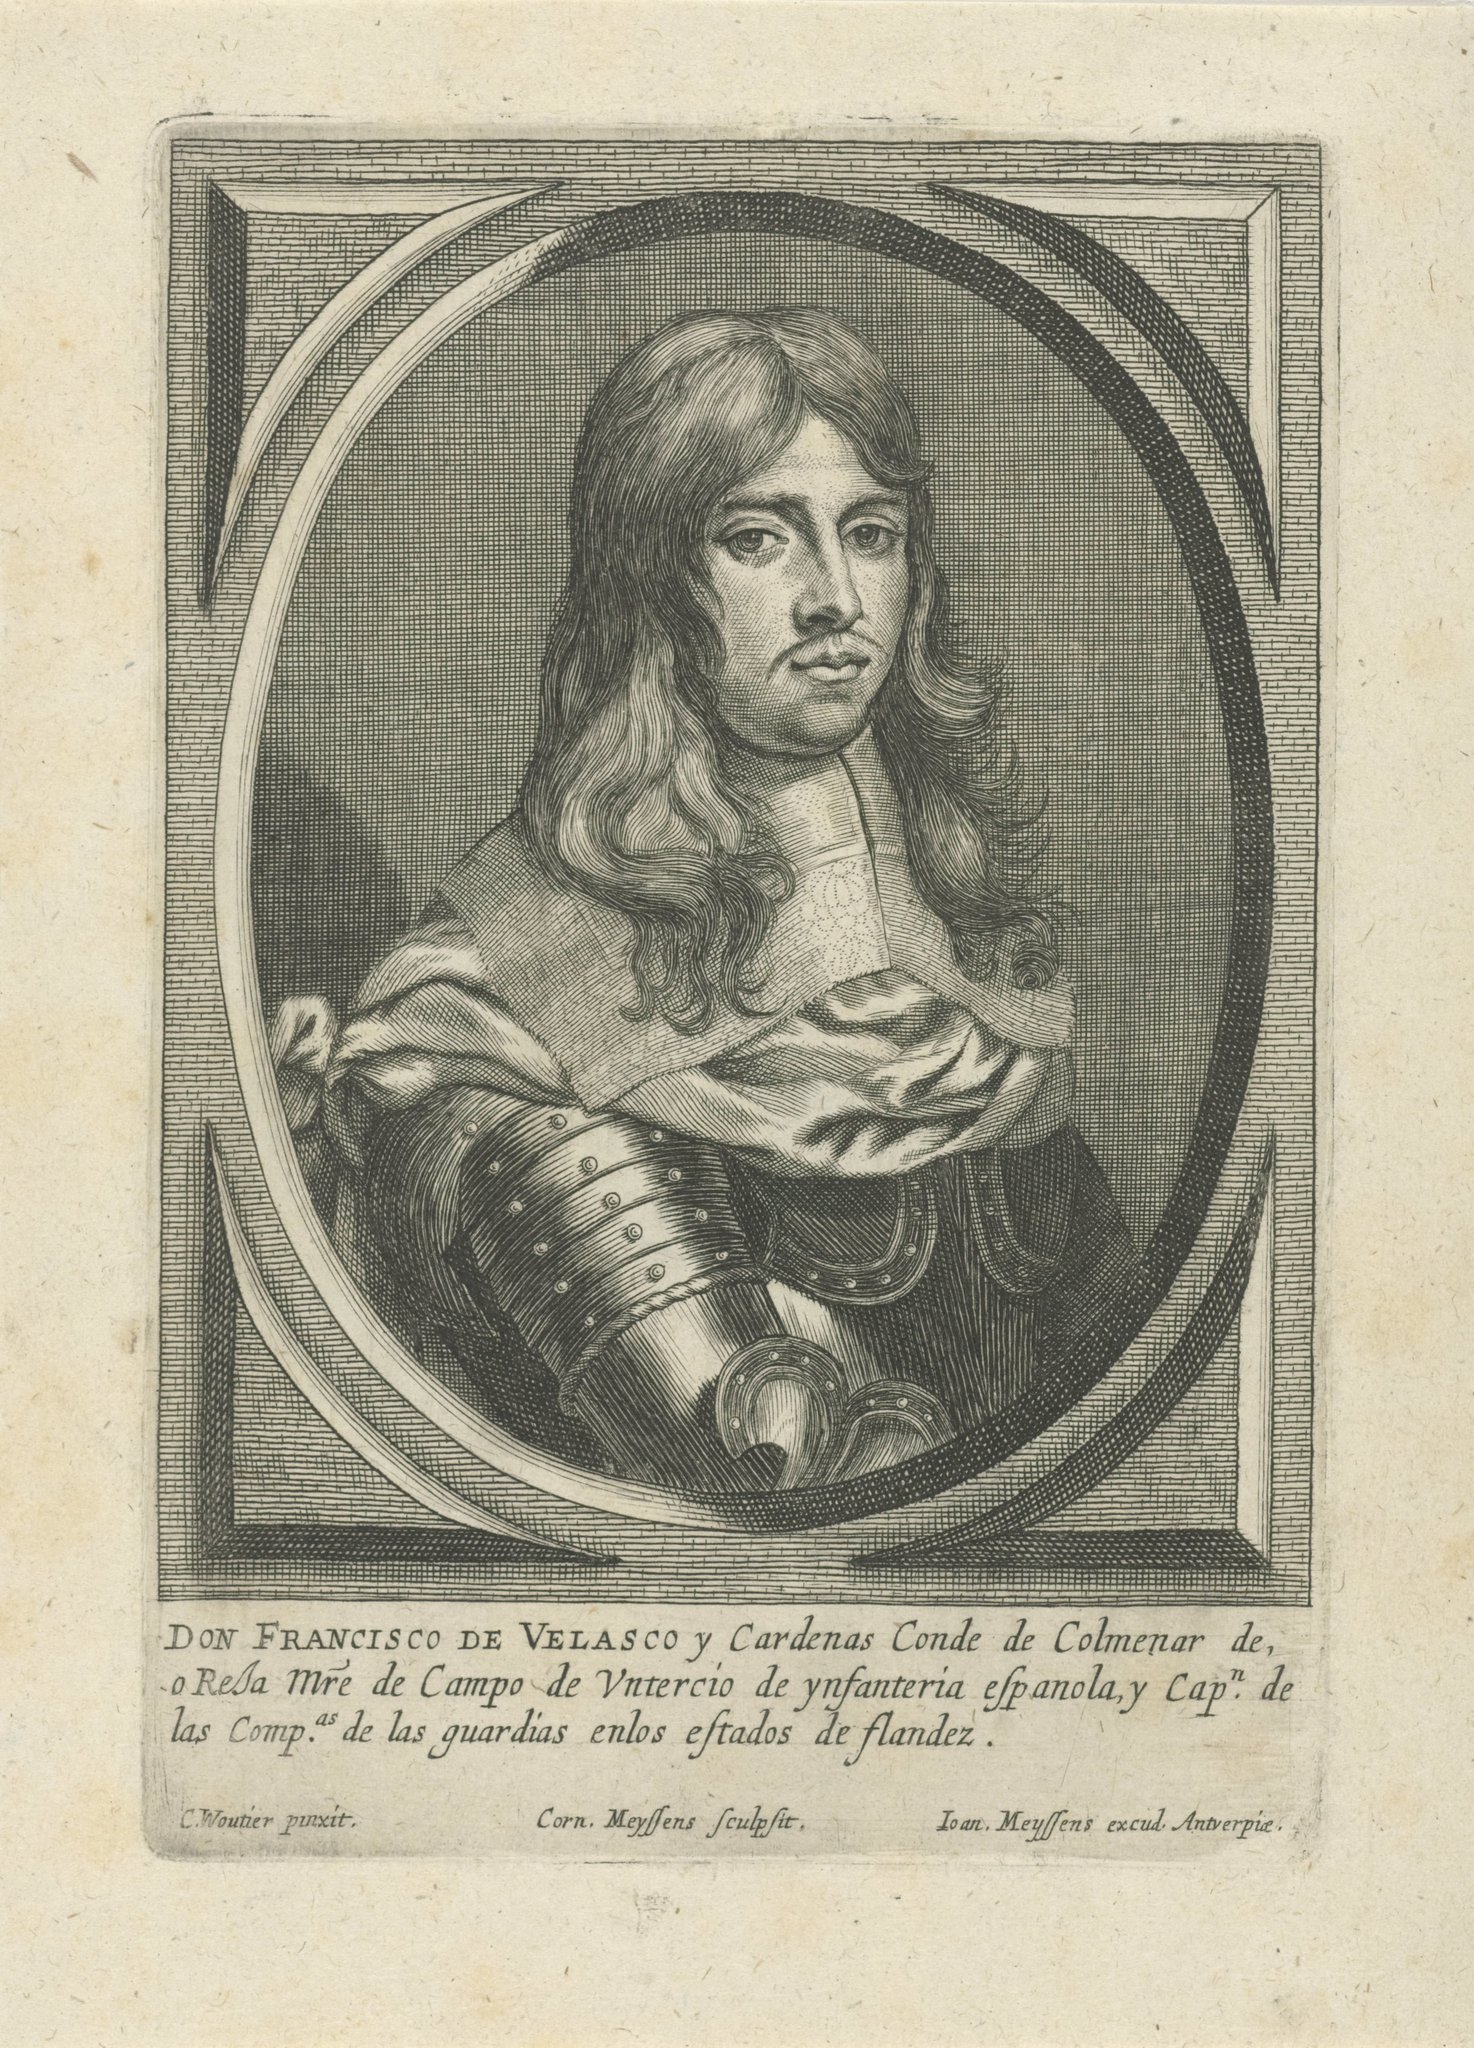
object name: print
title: Portret van Don Francisco Velasco y Cardenas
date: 1650-1670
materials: paper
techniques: engraving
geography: antwerp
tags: militair, don francisco velasco y cardenas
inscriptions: collector's mark: Lugt 2228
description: Portret van Don Francisco Velasco y Cardenas. Onderaan in demarge zijn titel en functie in het Spaans.